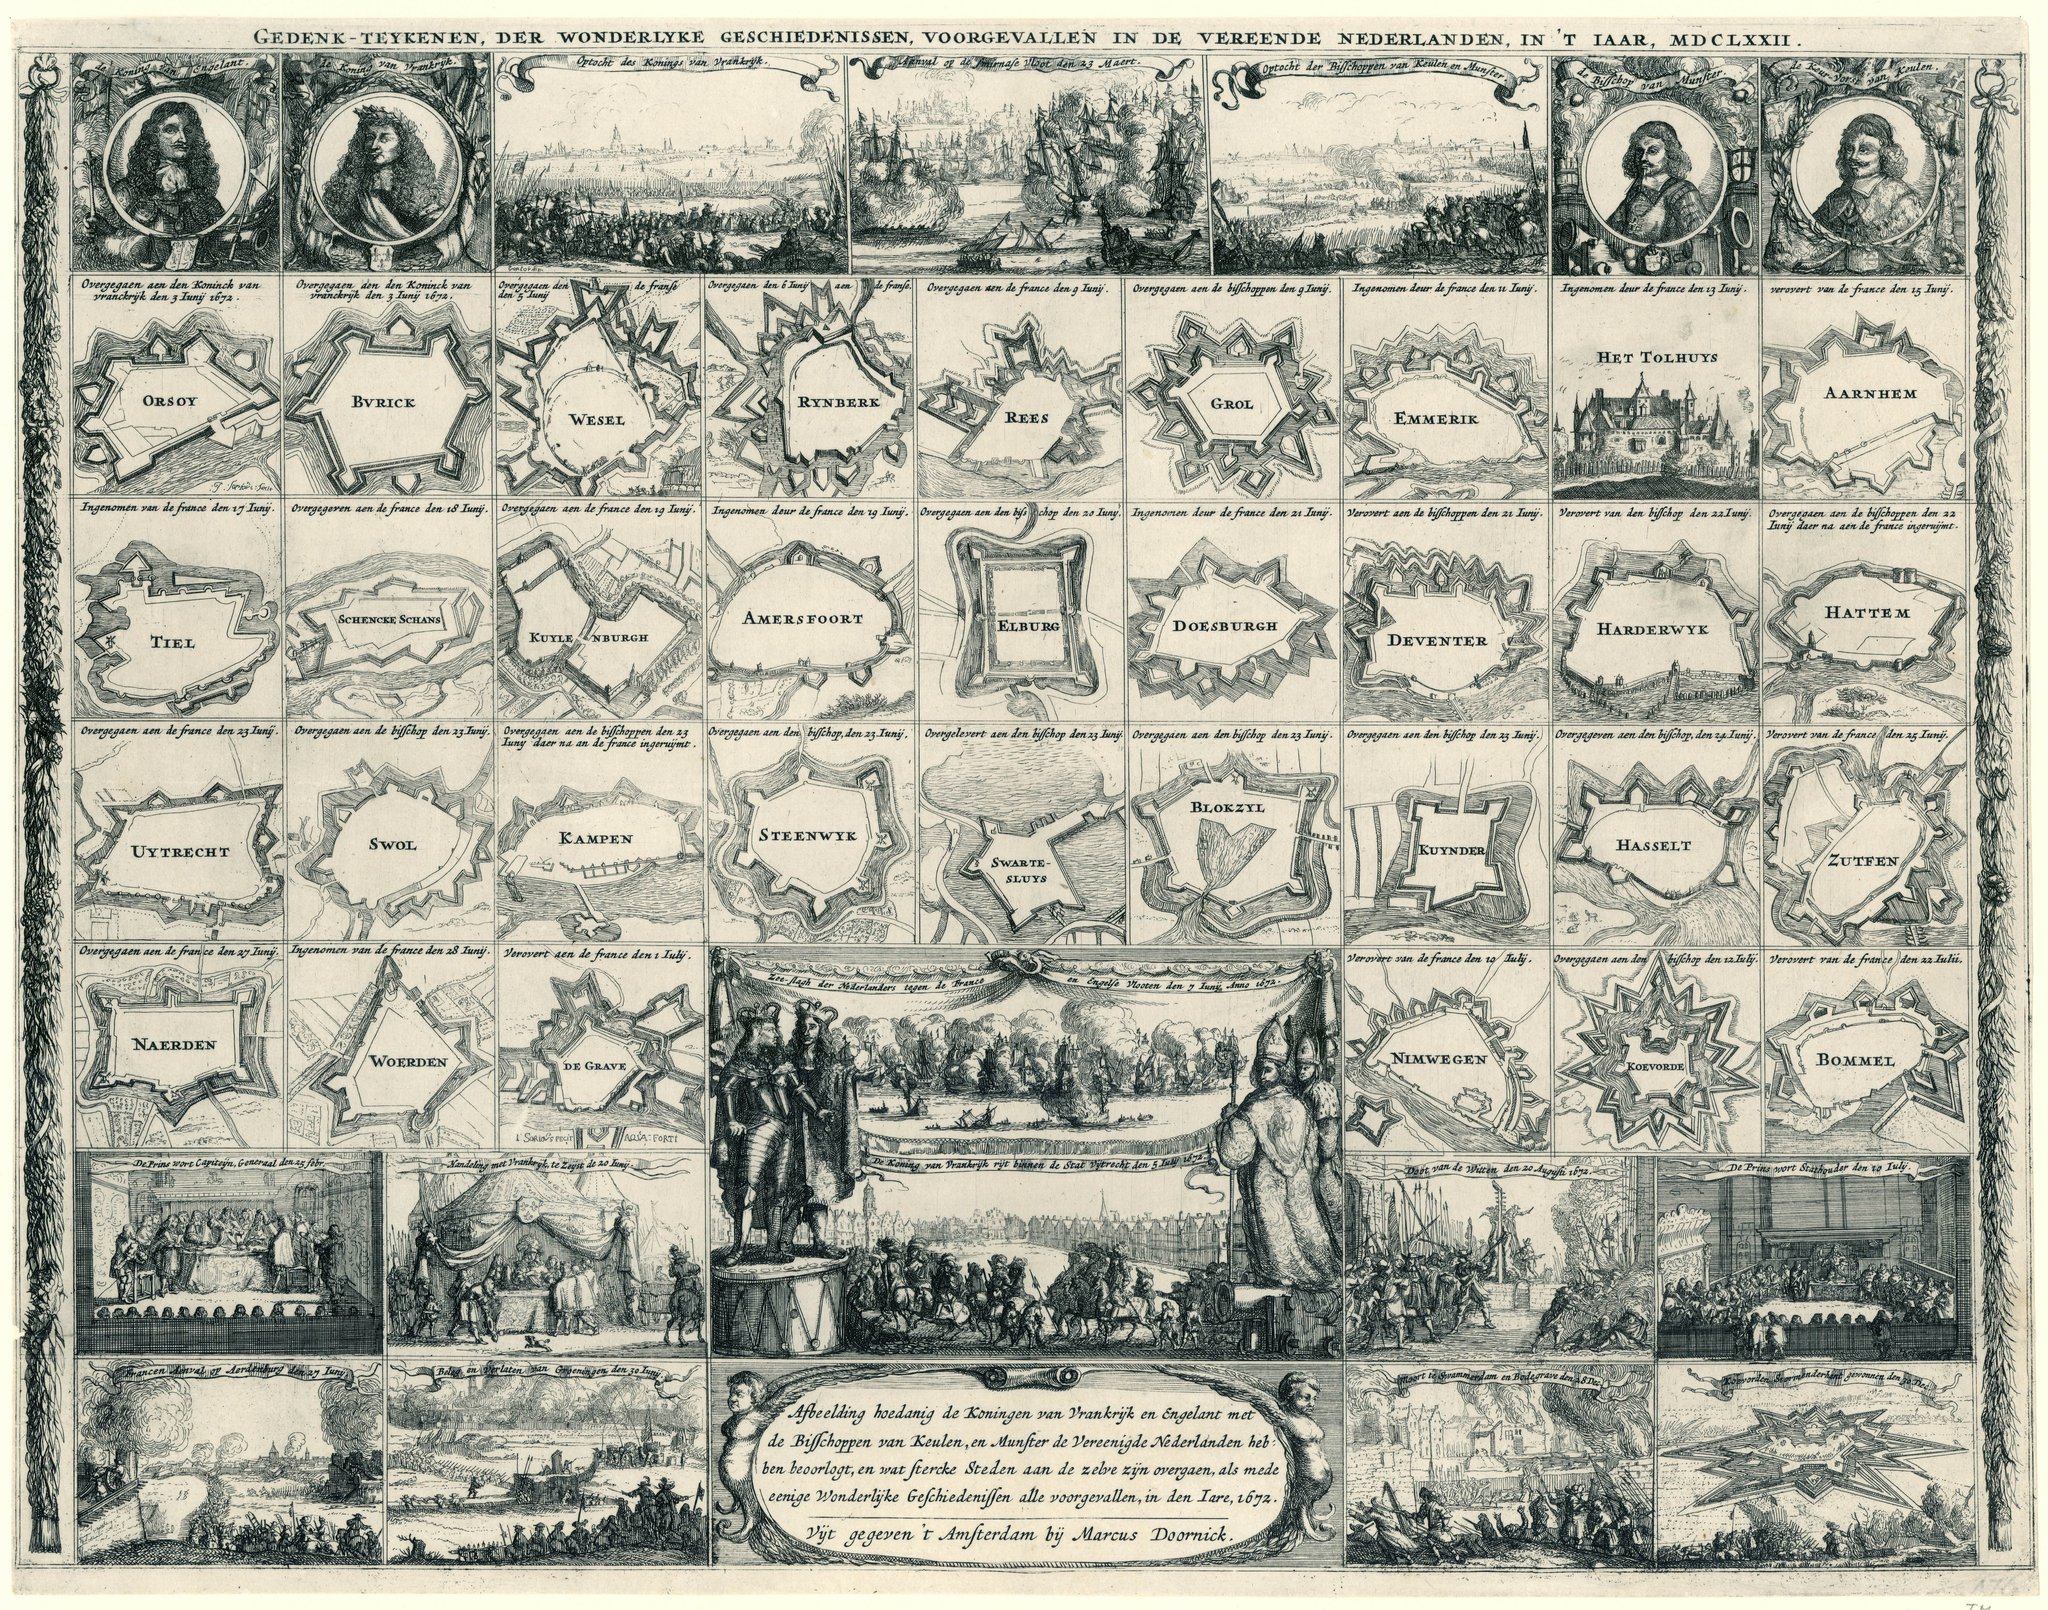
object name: print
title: Drie platen over de gebeurtenissen vanaf 1672 tot aan de vrede in 1674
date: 1672-1673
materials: paper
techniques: etching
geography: northern netherlands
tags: lodewijk xiv (koning van frankrijk), maximiliaan hendrik van beieren, london, karel ii (koning van engeland), fortress, utrecht, deventer, nijmegen, grave, arnhem, rampjaar (disaster year)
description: Prent met een overzicht van verschillende gebeurtenissen voorgevallen in 1672 en alle steden, vestingen en bouwwerken die in dat jaar in de oorlog aan de Engelsen, Fransen en aan de bisschop van Munster zijn verloren.